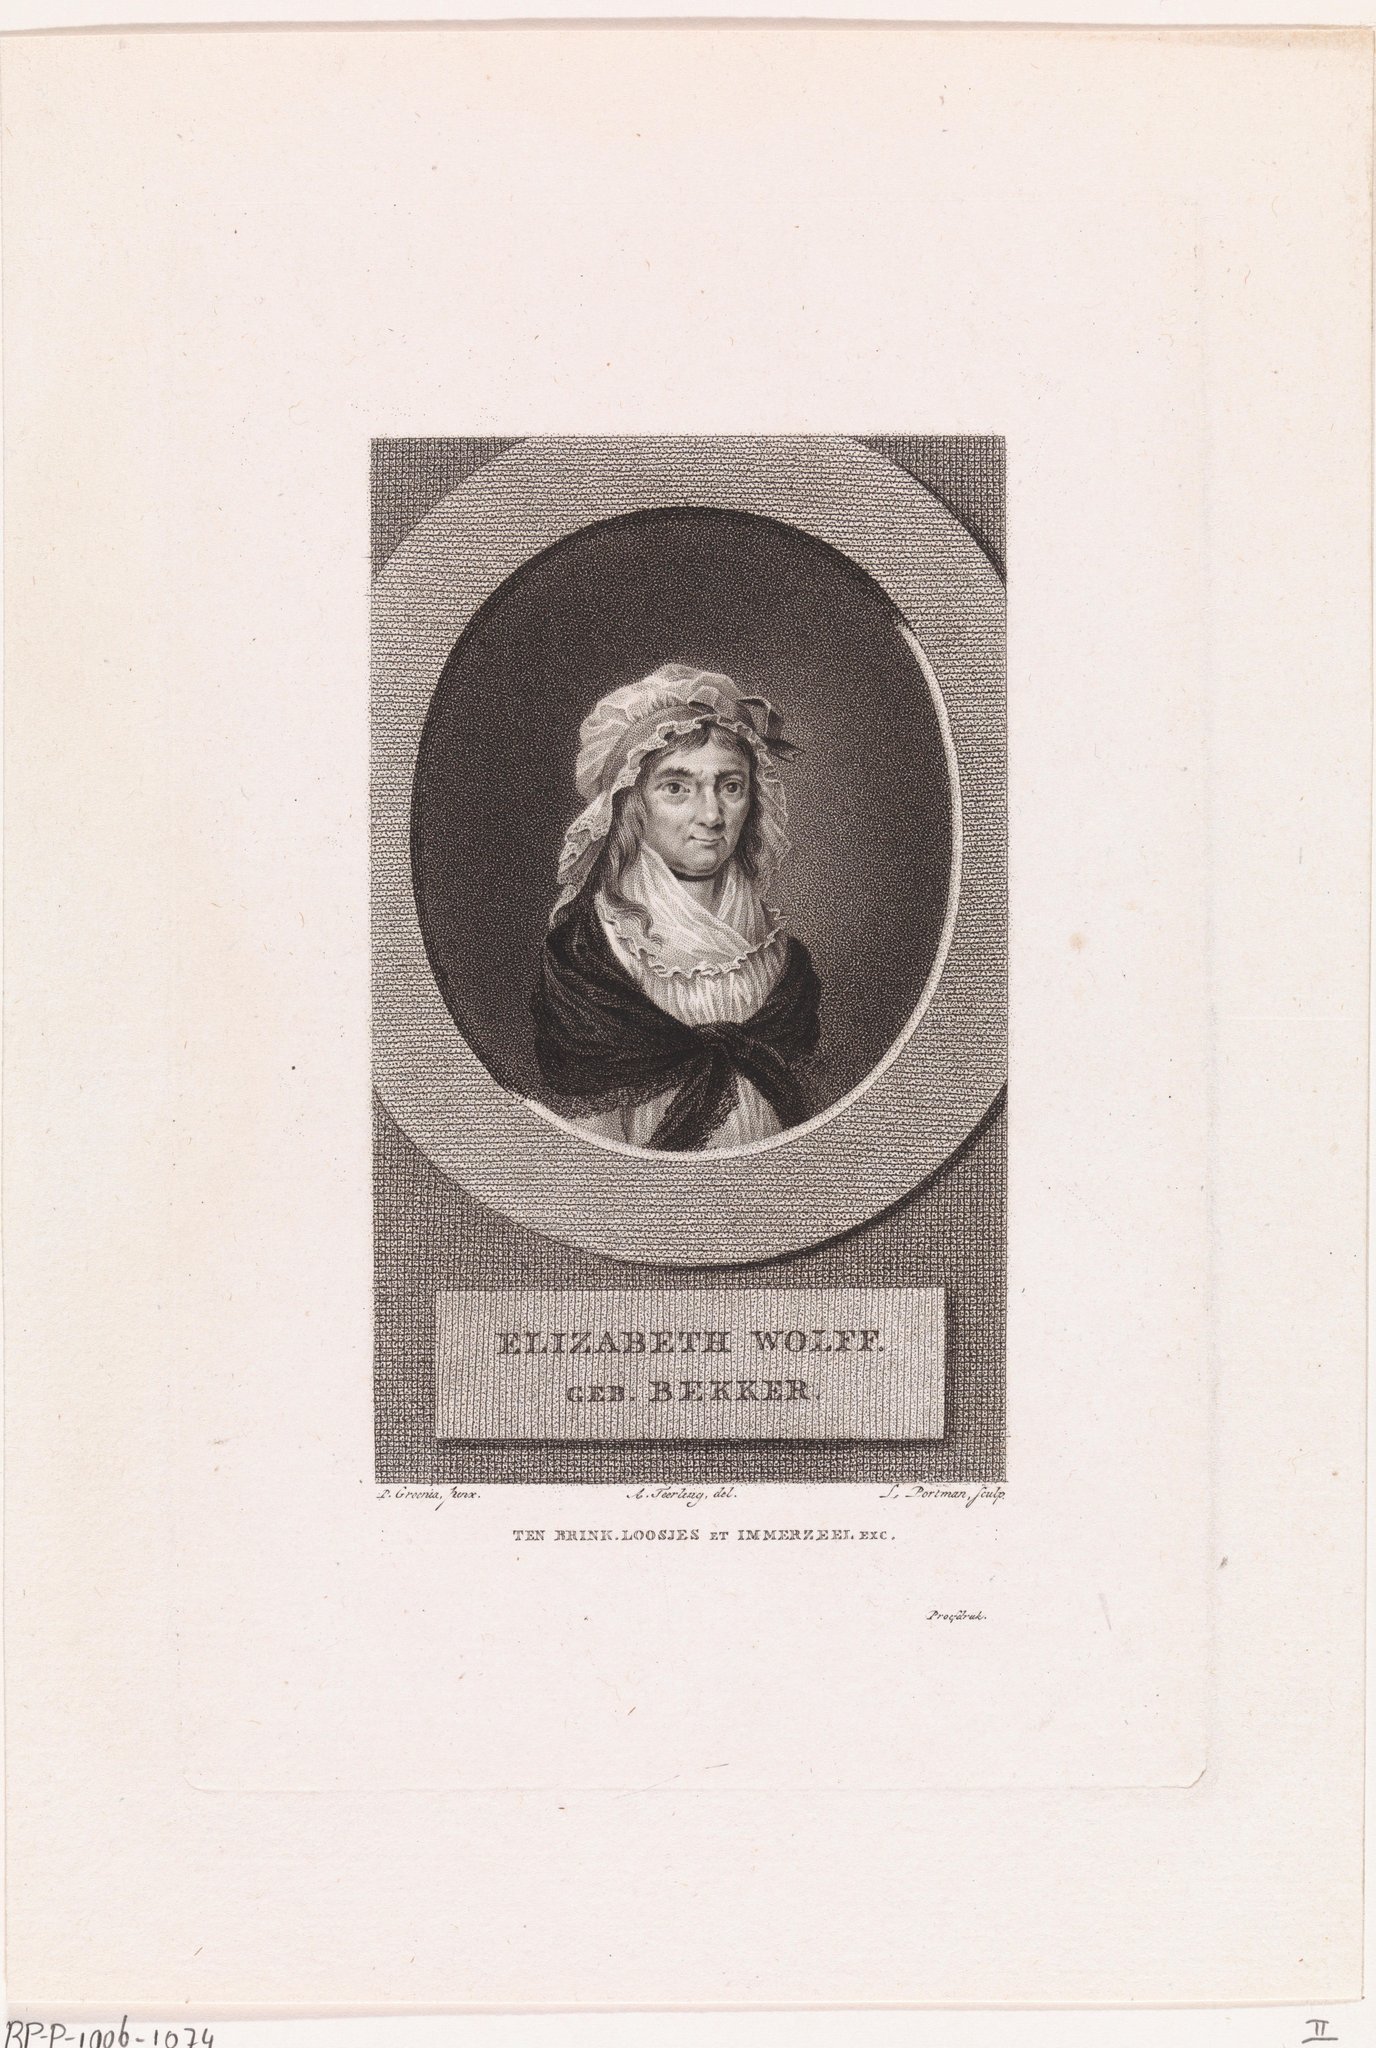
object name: print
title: Portrait of the Poetess Elisabeth Wolff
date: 1805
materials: paper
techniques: etching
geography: the hague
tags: flushing, the hague, elisabeth bekker, portrait of a writer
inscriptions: collector's mark: Lugt 2228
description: When the Dutch Patriot movement is crushed in 1787, many of its leaders flee to France. In 1788, Wolff and Deken also leave the country. They settle in Trévoux, near Lyon, until they are forced to return to the Netherlands in 1797 for financial reasons. They spend their last years in poverty. Wolff dies after a long illness on 5 November 1804, Deken a mere nine days thereafter. One year later, these portraits are published.